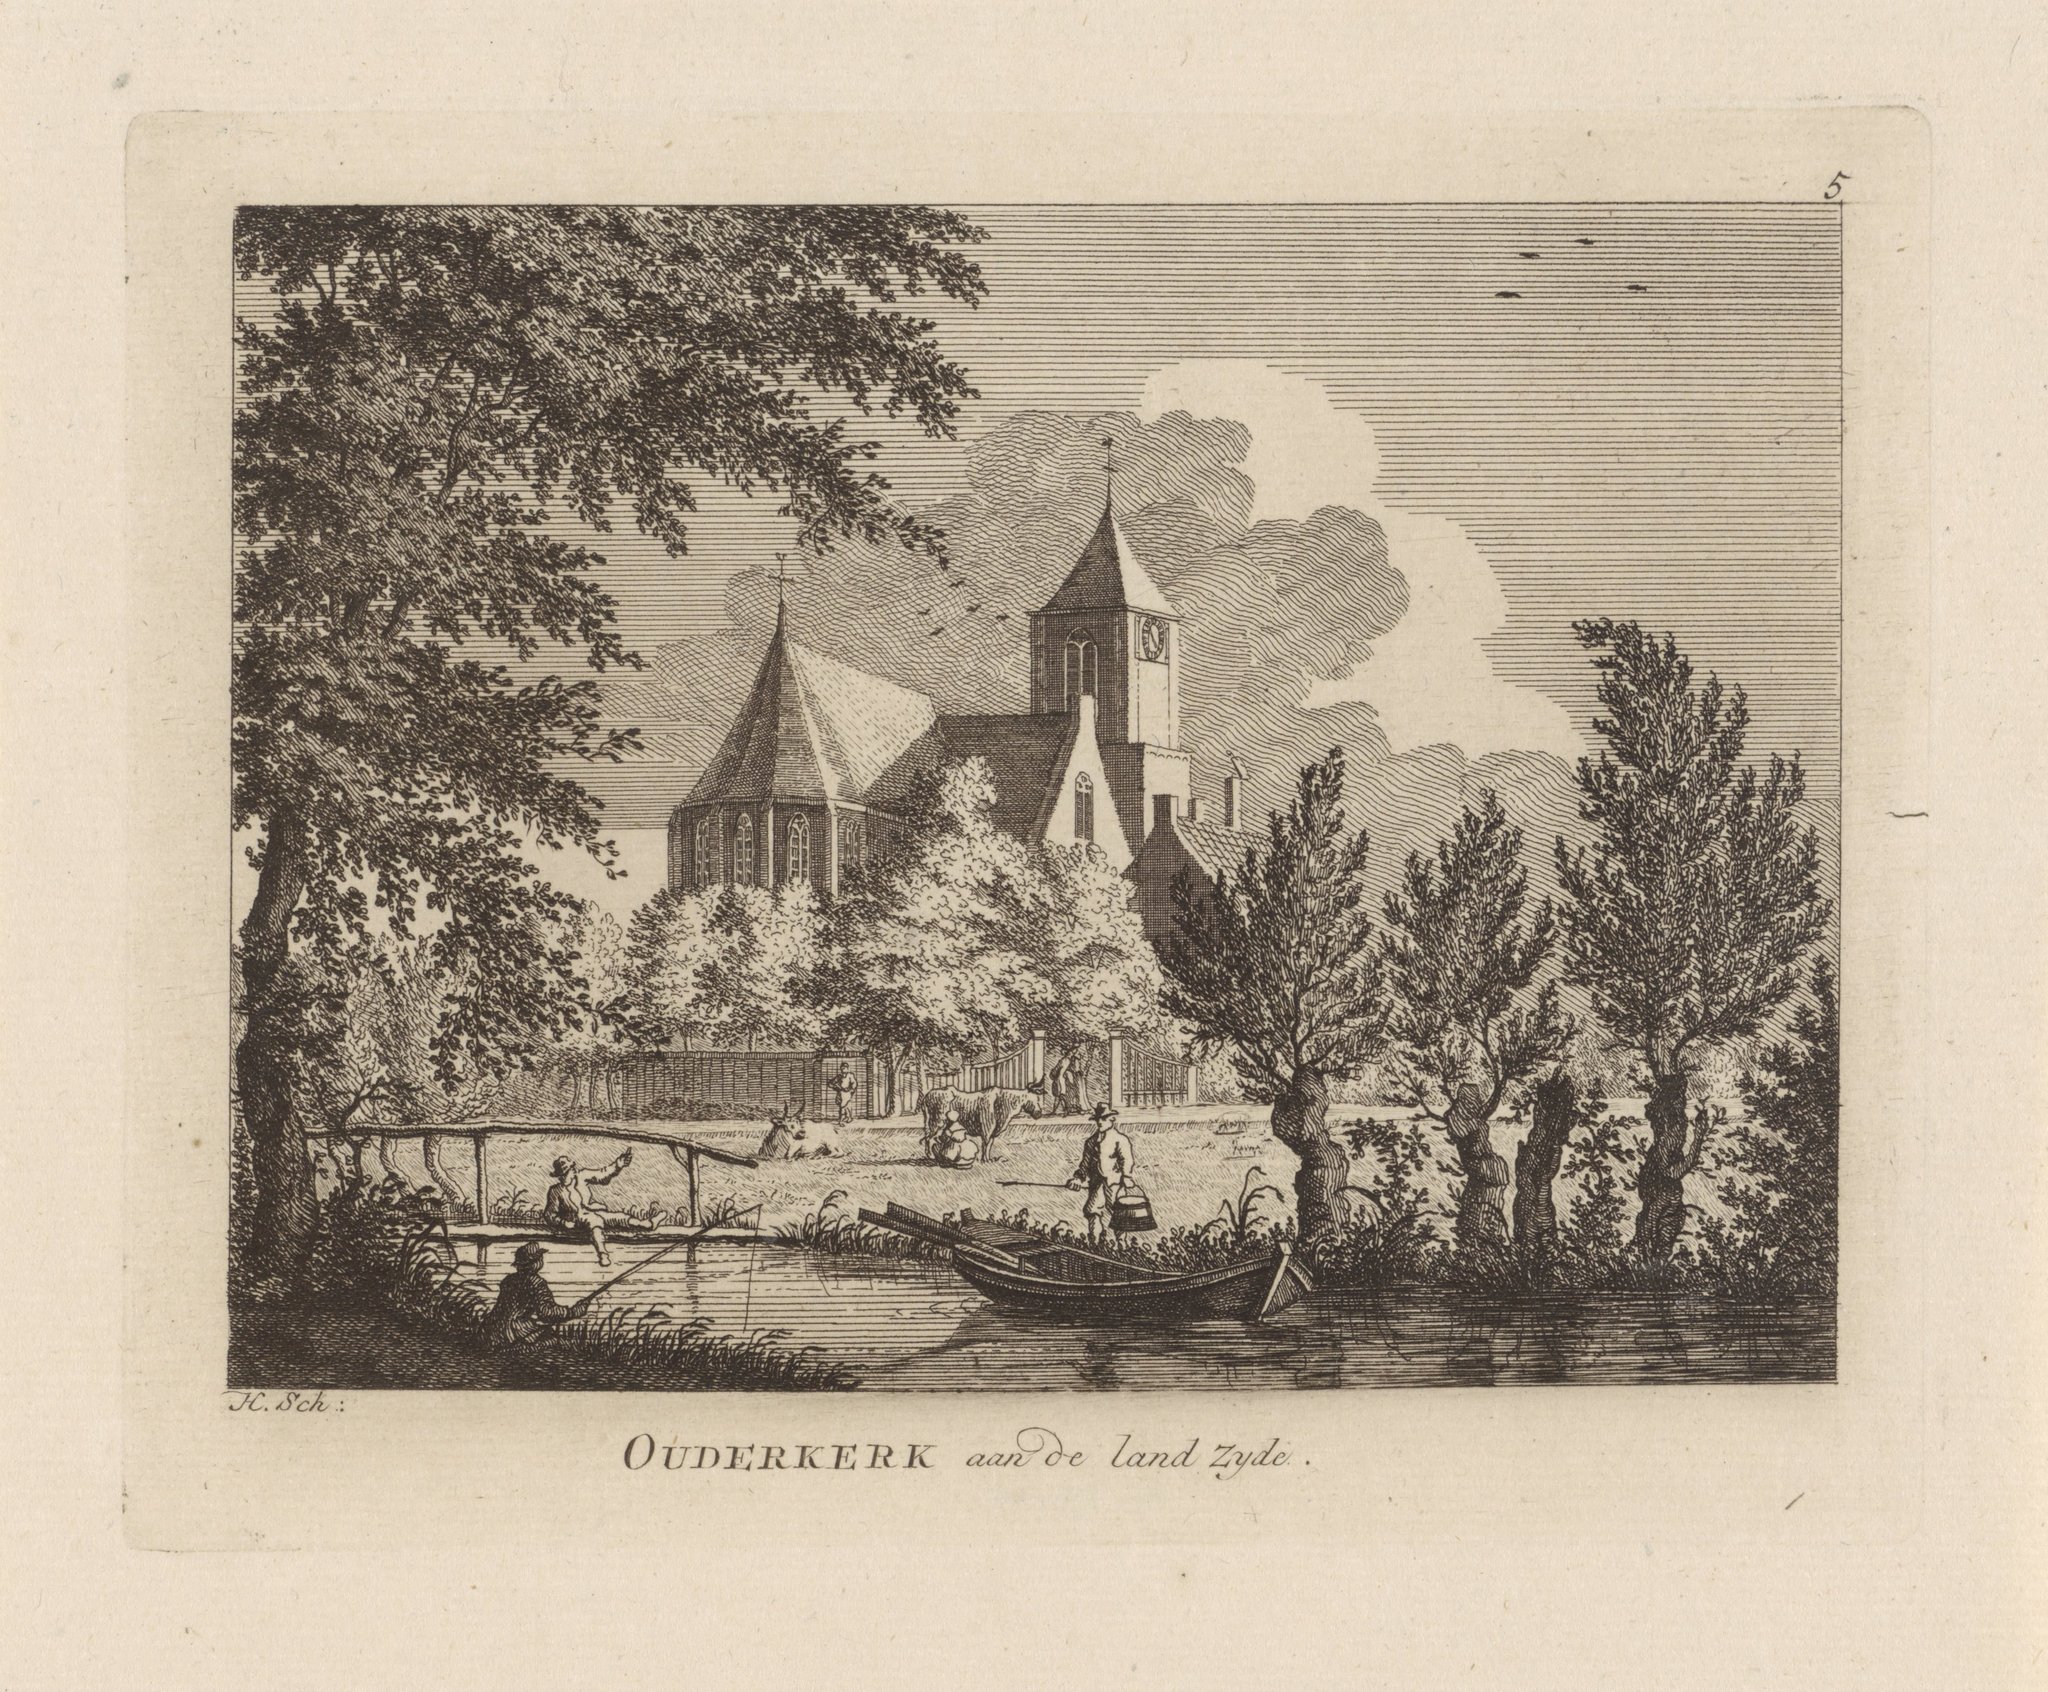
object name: print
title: Gezicht op Ouderkerk aan de Amstel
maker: hermanus petrus schouten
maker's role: draughtsman, painter, print maker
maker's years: 1747-1822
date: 1762-1822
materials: paper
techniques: etching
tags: ouderkerk aan de amstel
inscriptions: collector's mark: Lugt 2228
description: Landelijk tafereel bij een sloot met knotwilgen met zicht op de kerk in Ouderkerk aan de Amstel. Rechtsboven genummerd "5".